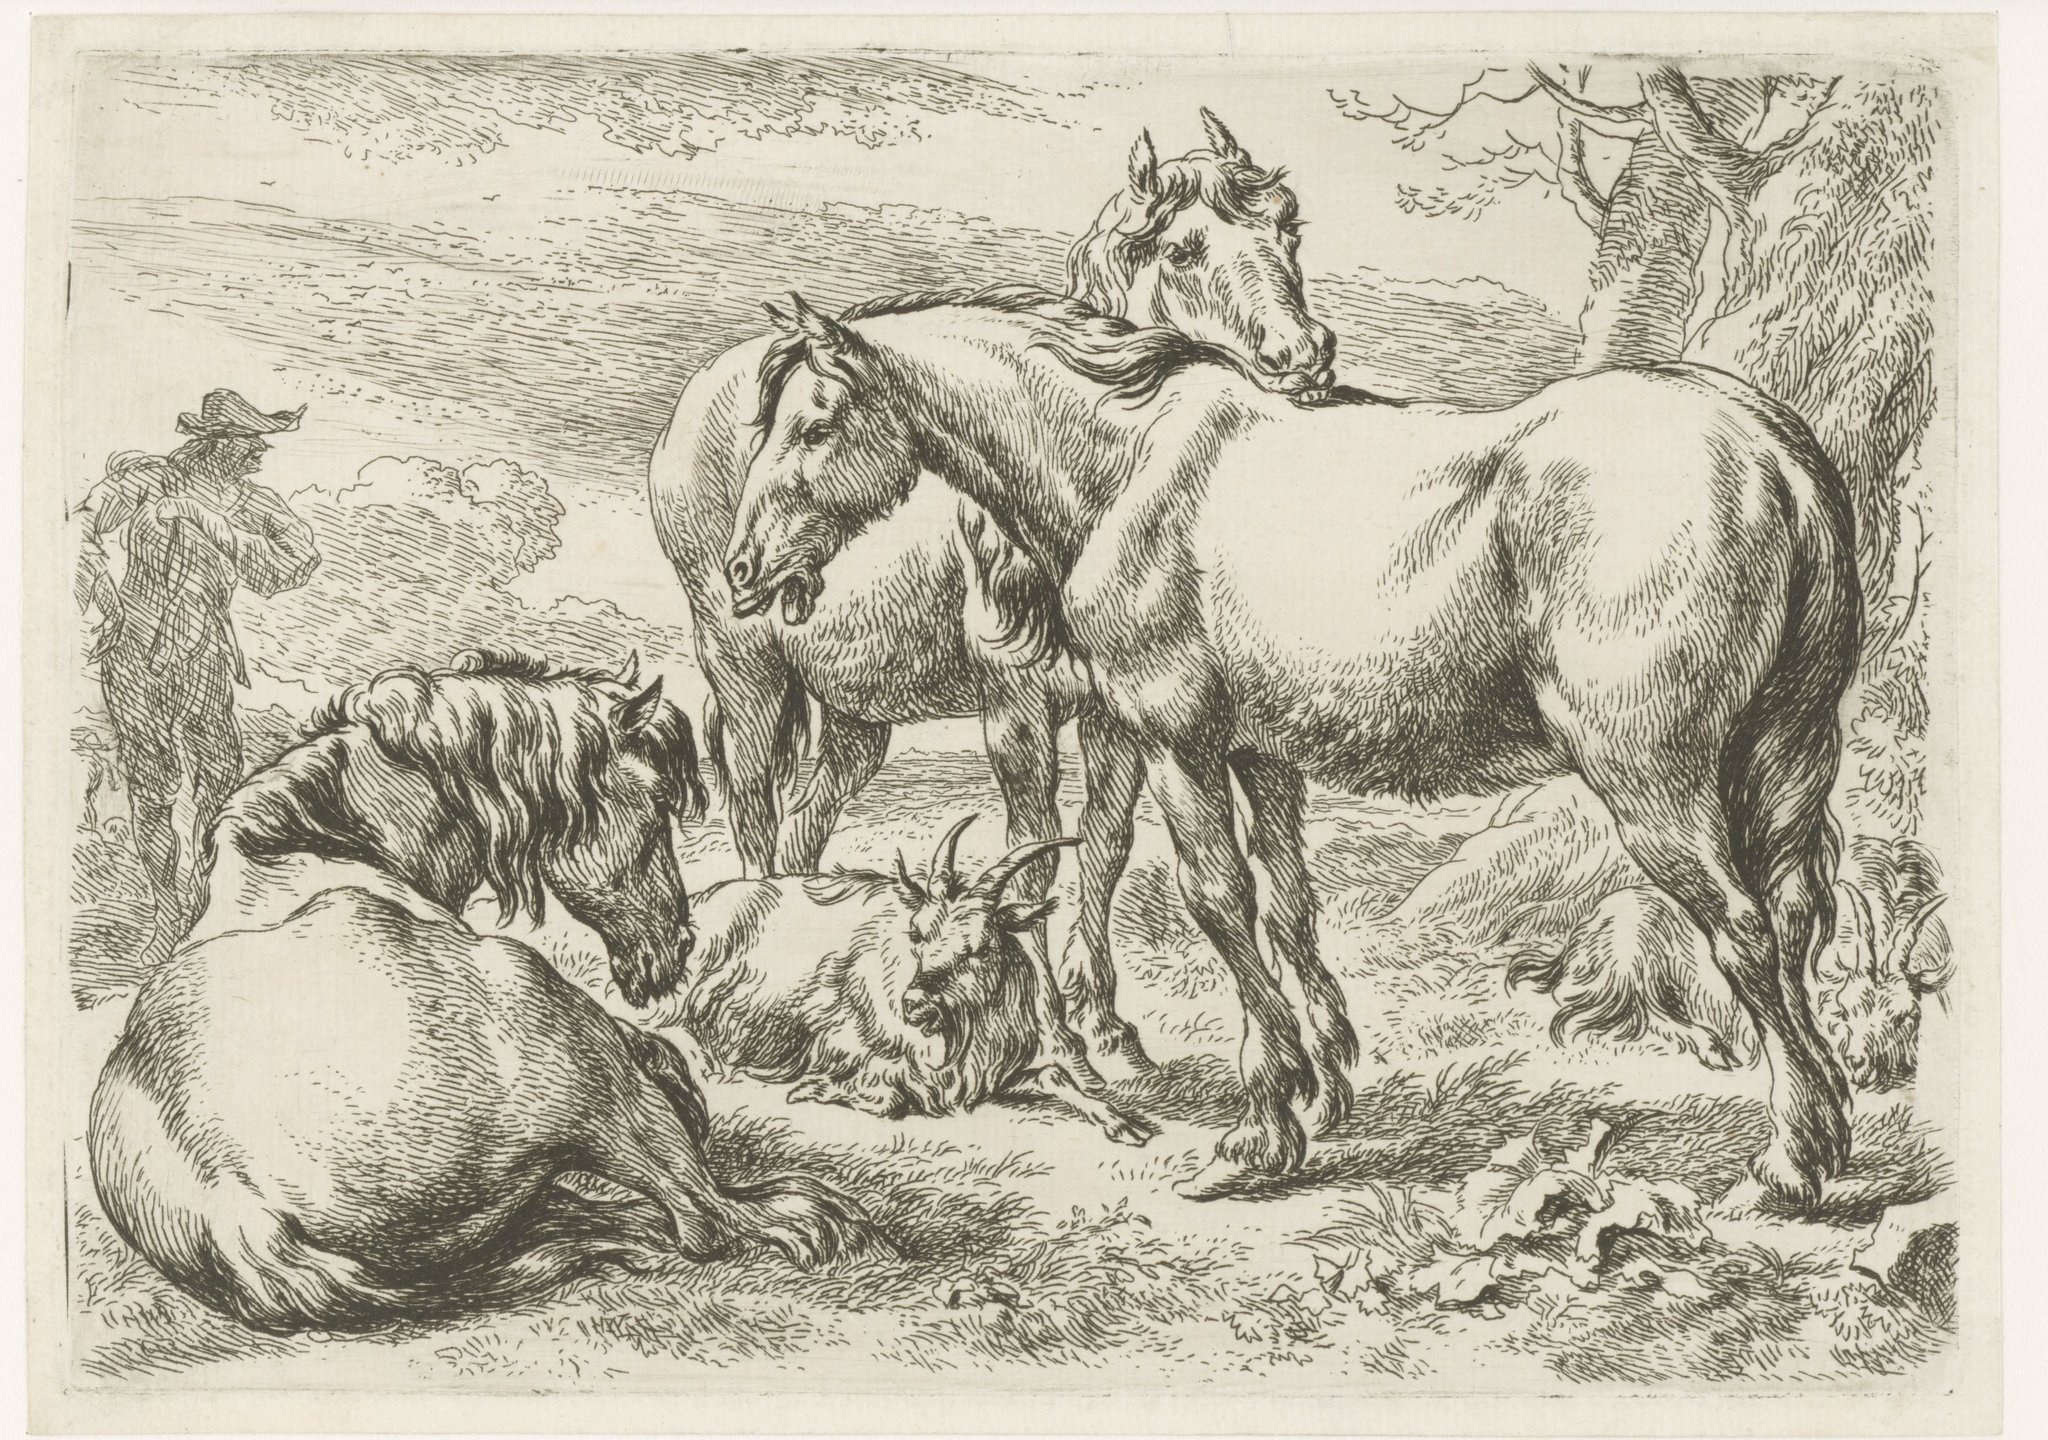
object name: print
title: Drie paarden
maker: nicolaes pietersz berchem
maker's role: draughtsman, print maker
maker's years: 1620-1683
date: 1679-1680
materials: paper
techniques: etching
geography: netherlands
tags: horse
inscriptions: collector's mark: Lugt 240